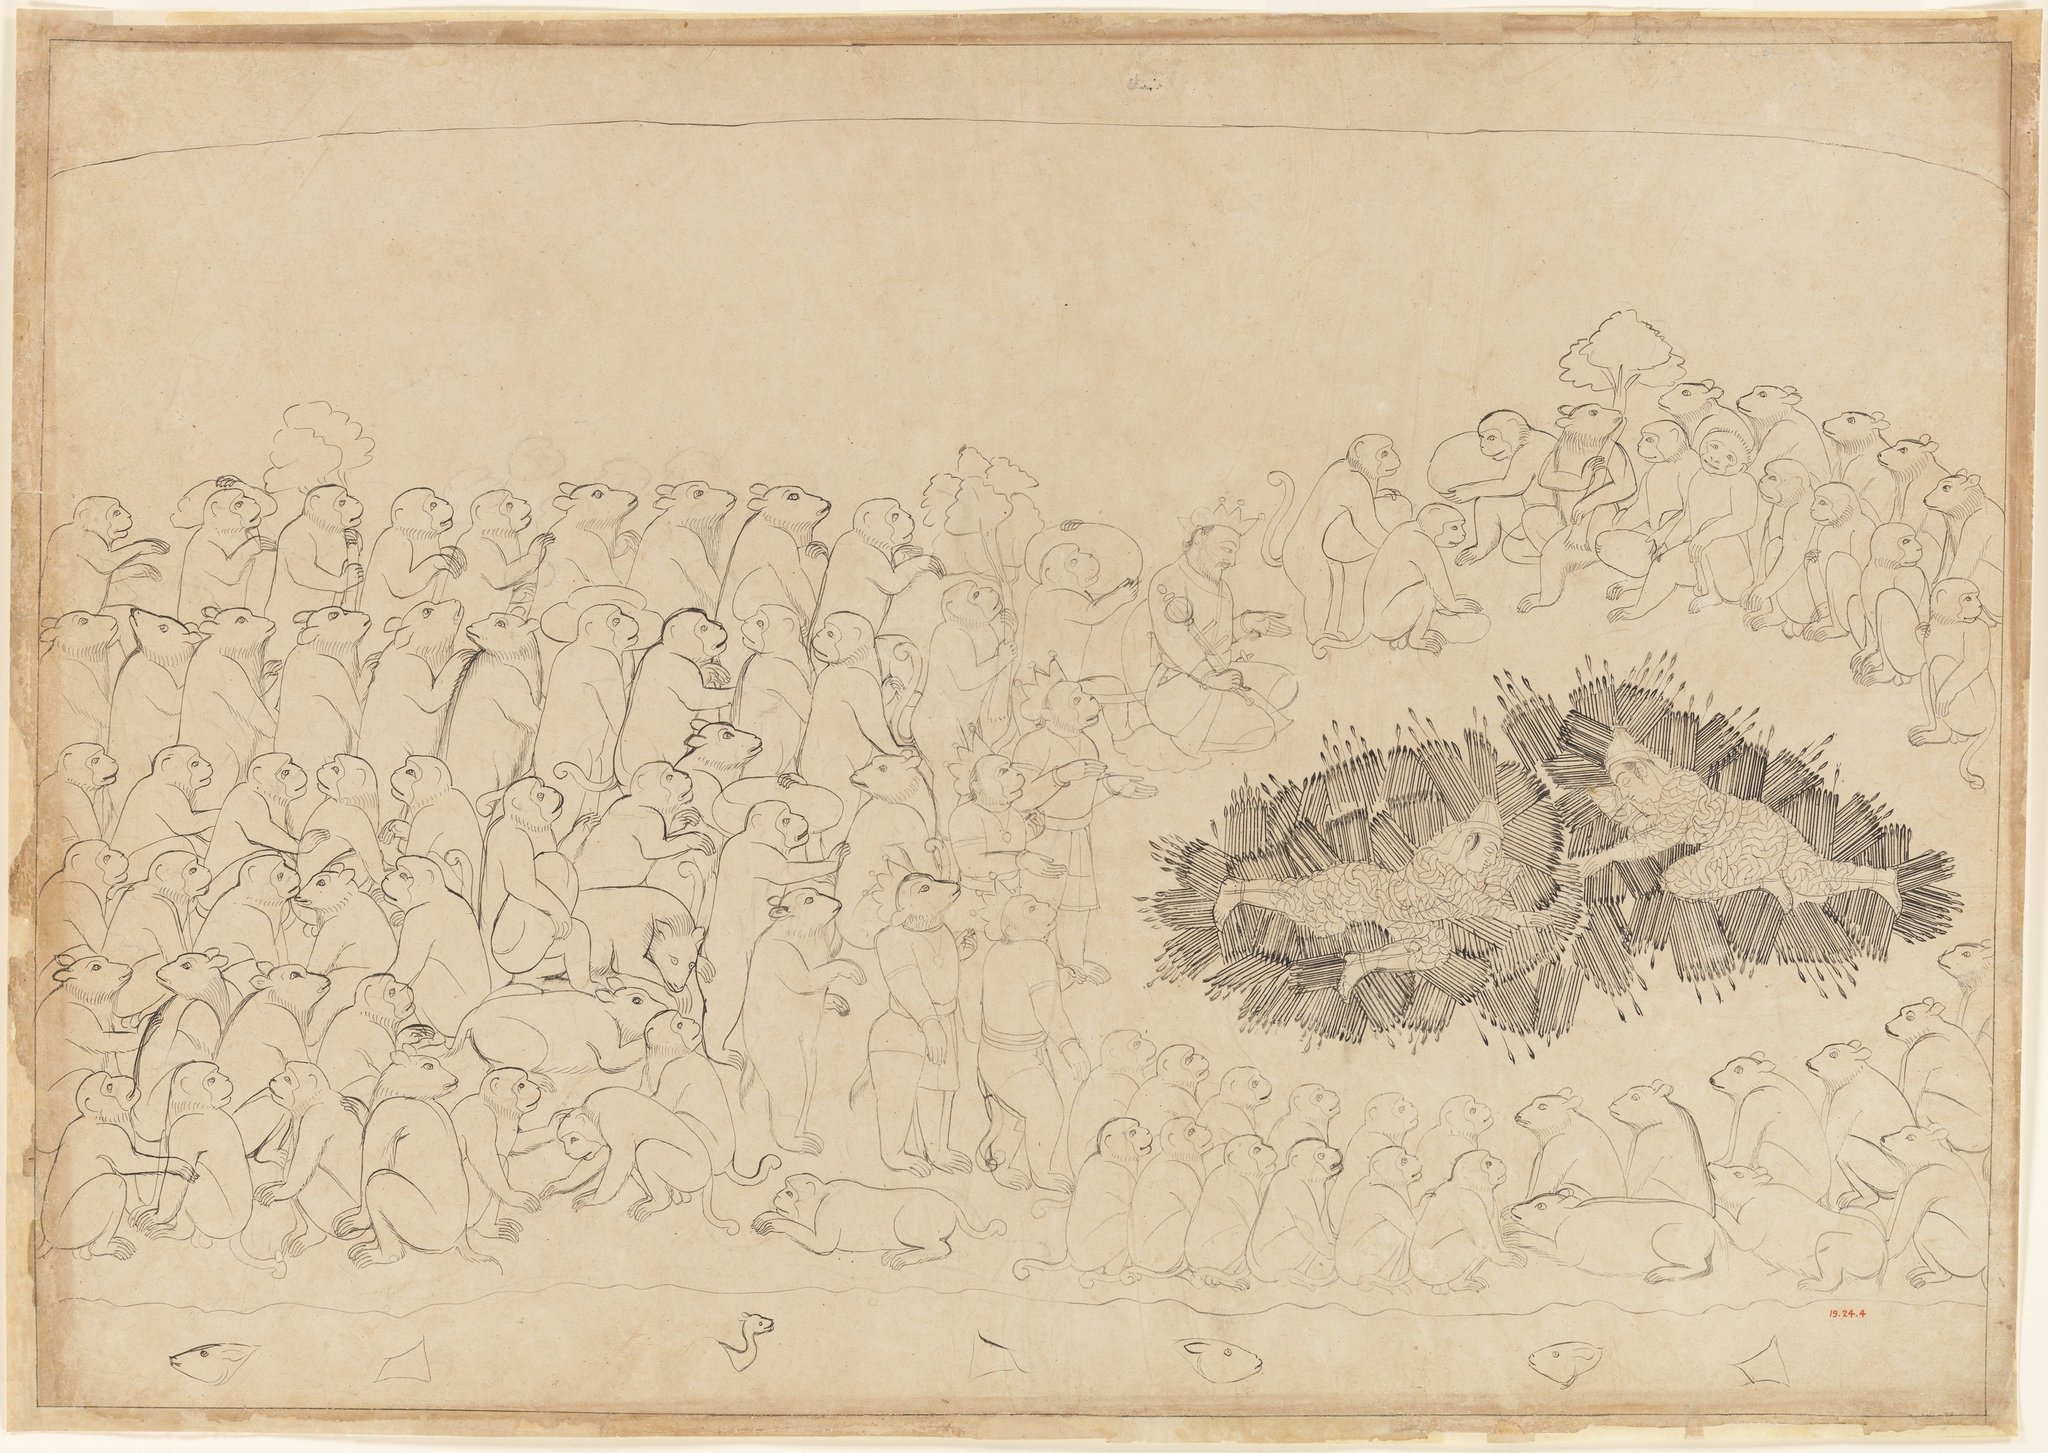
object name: drawing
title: Rama and Lakshmana Overwhelmed by Arrows: Folio from the Siege of Lanka series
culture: indian, punjab hills, guler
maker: manaku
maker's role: artist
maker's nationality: indian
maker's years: 1715-1770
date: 1725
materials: ink, paper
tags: bears,arrows,monkeys